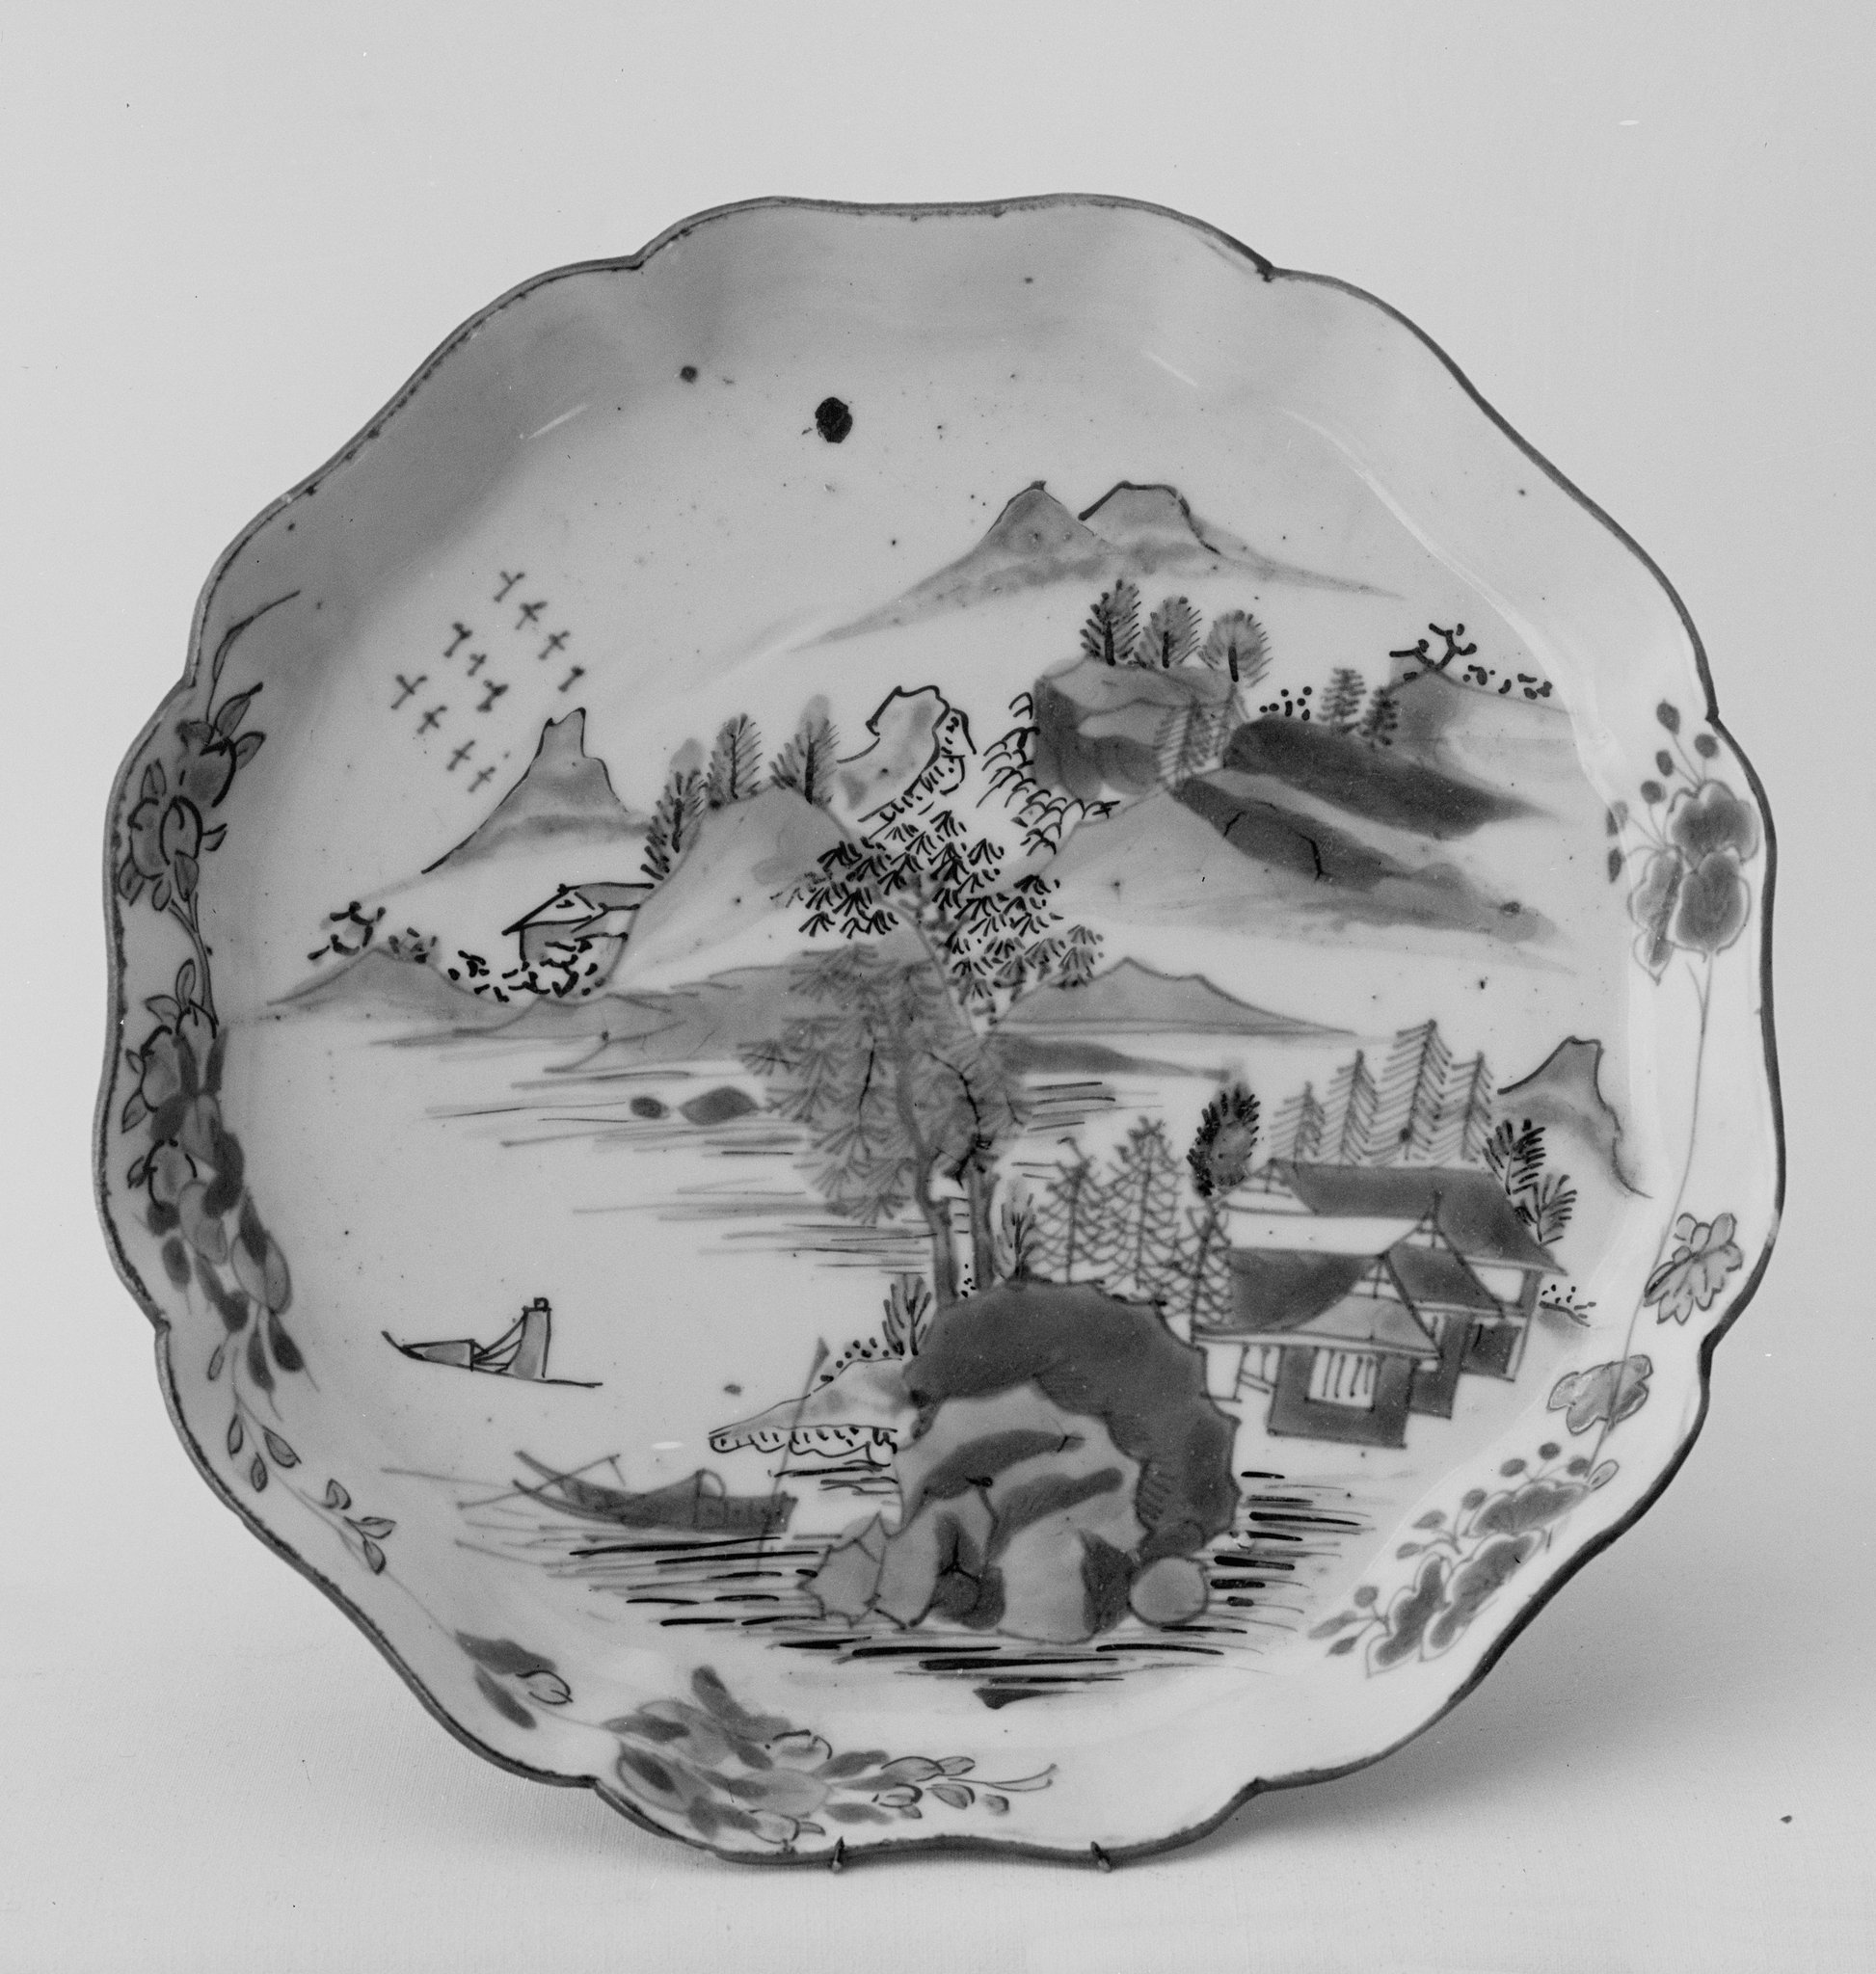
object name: dish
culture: chinese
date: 1626-1650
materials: enamel, porcelain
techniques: overglaze, painting, polychrome, underglaze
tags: houses,mountains,trees,boats